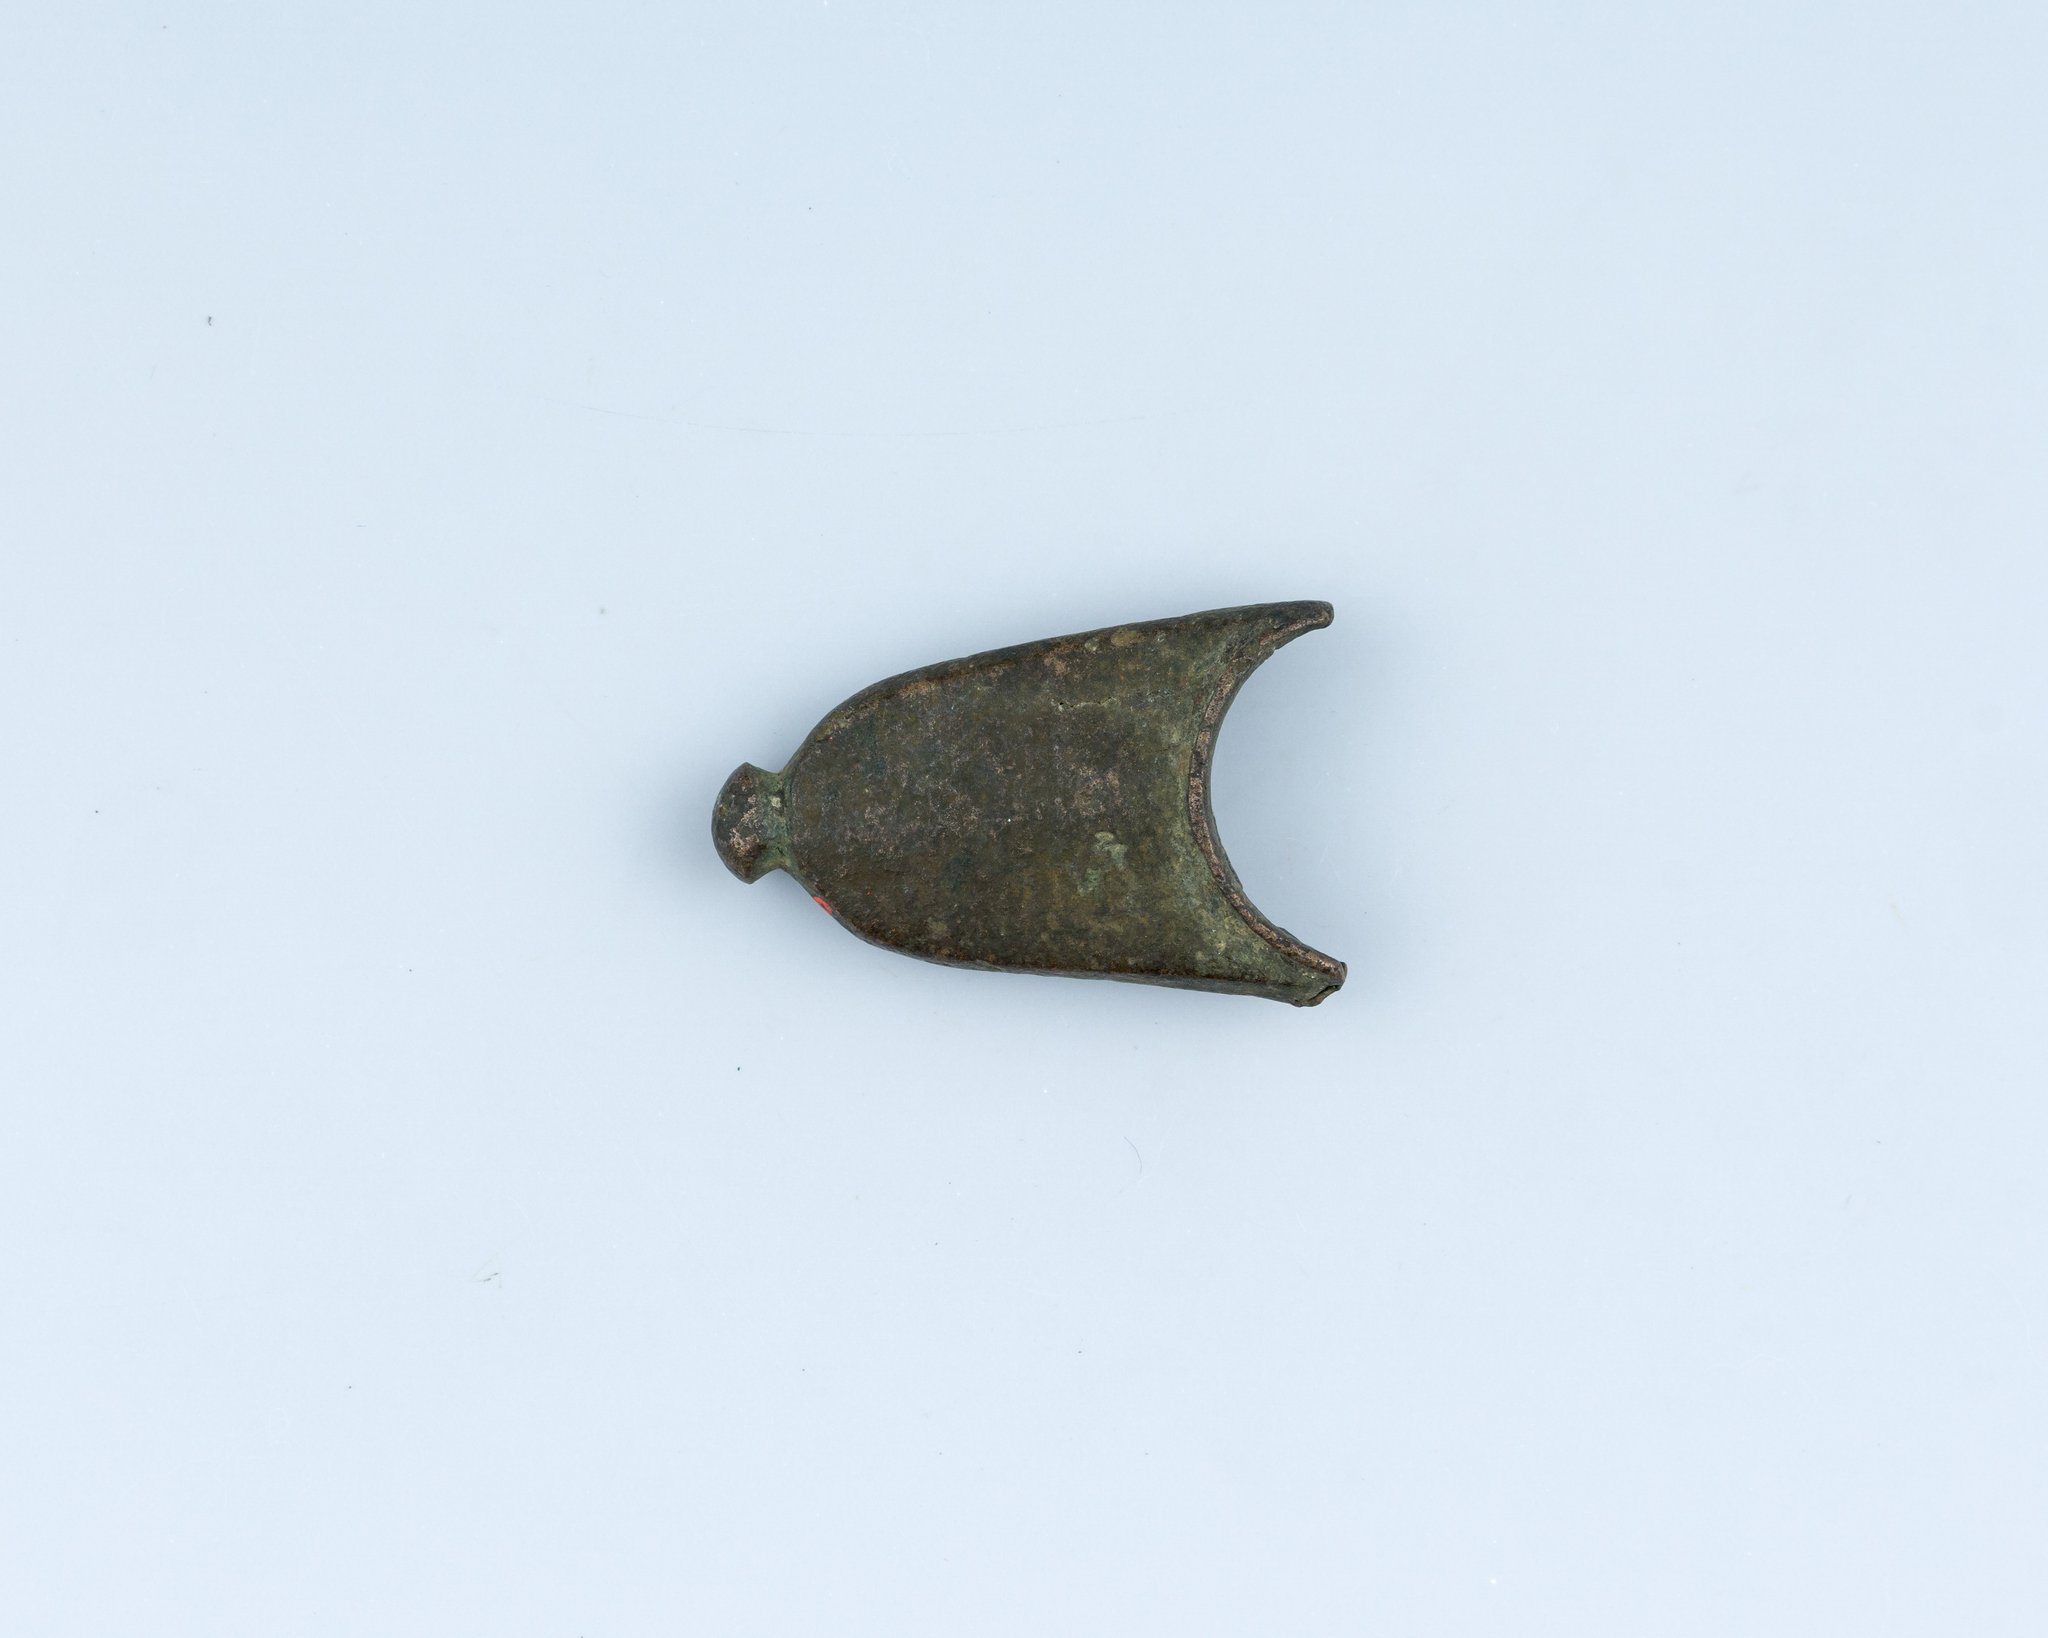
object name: mordant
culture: european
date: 1401-1700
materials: bronze